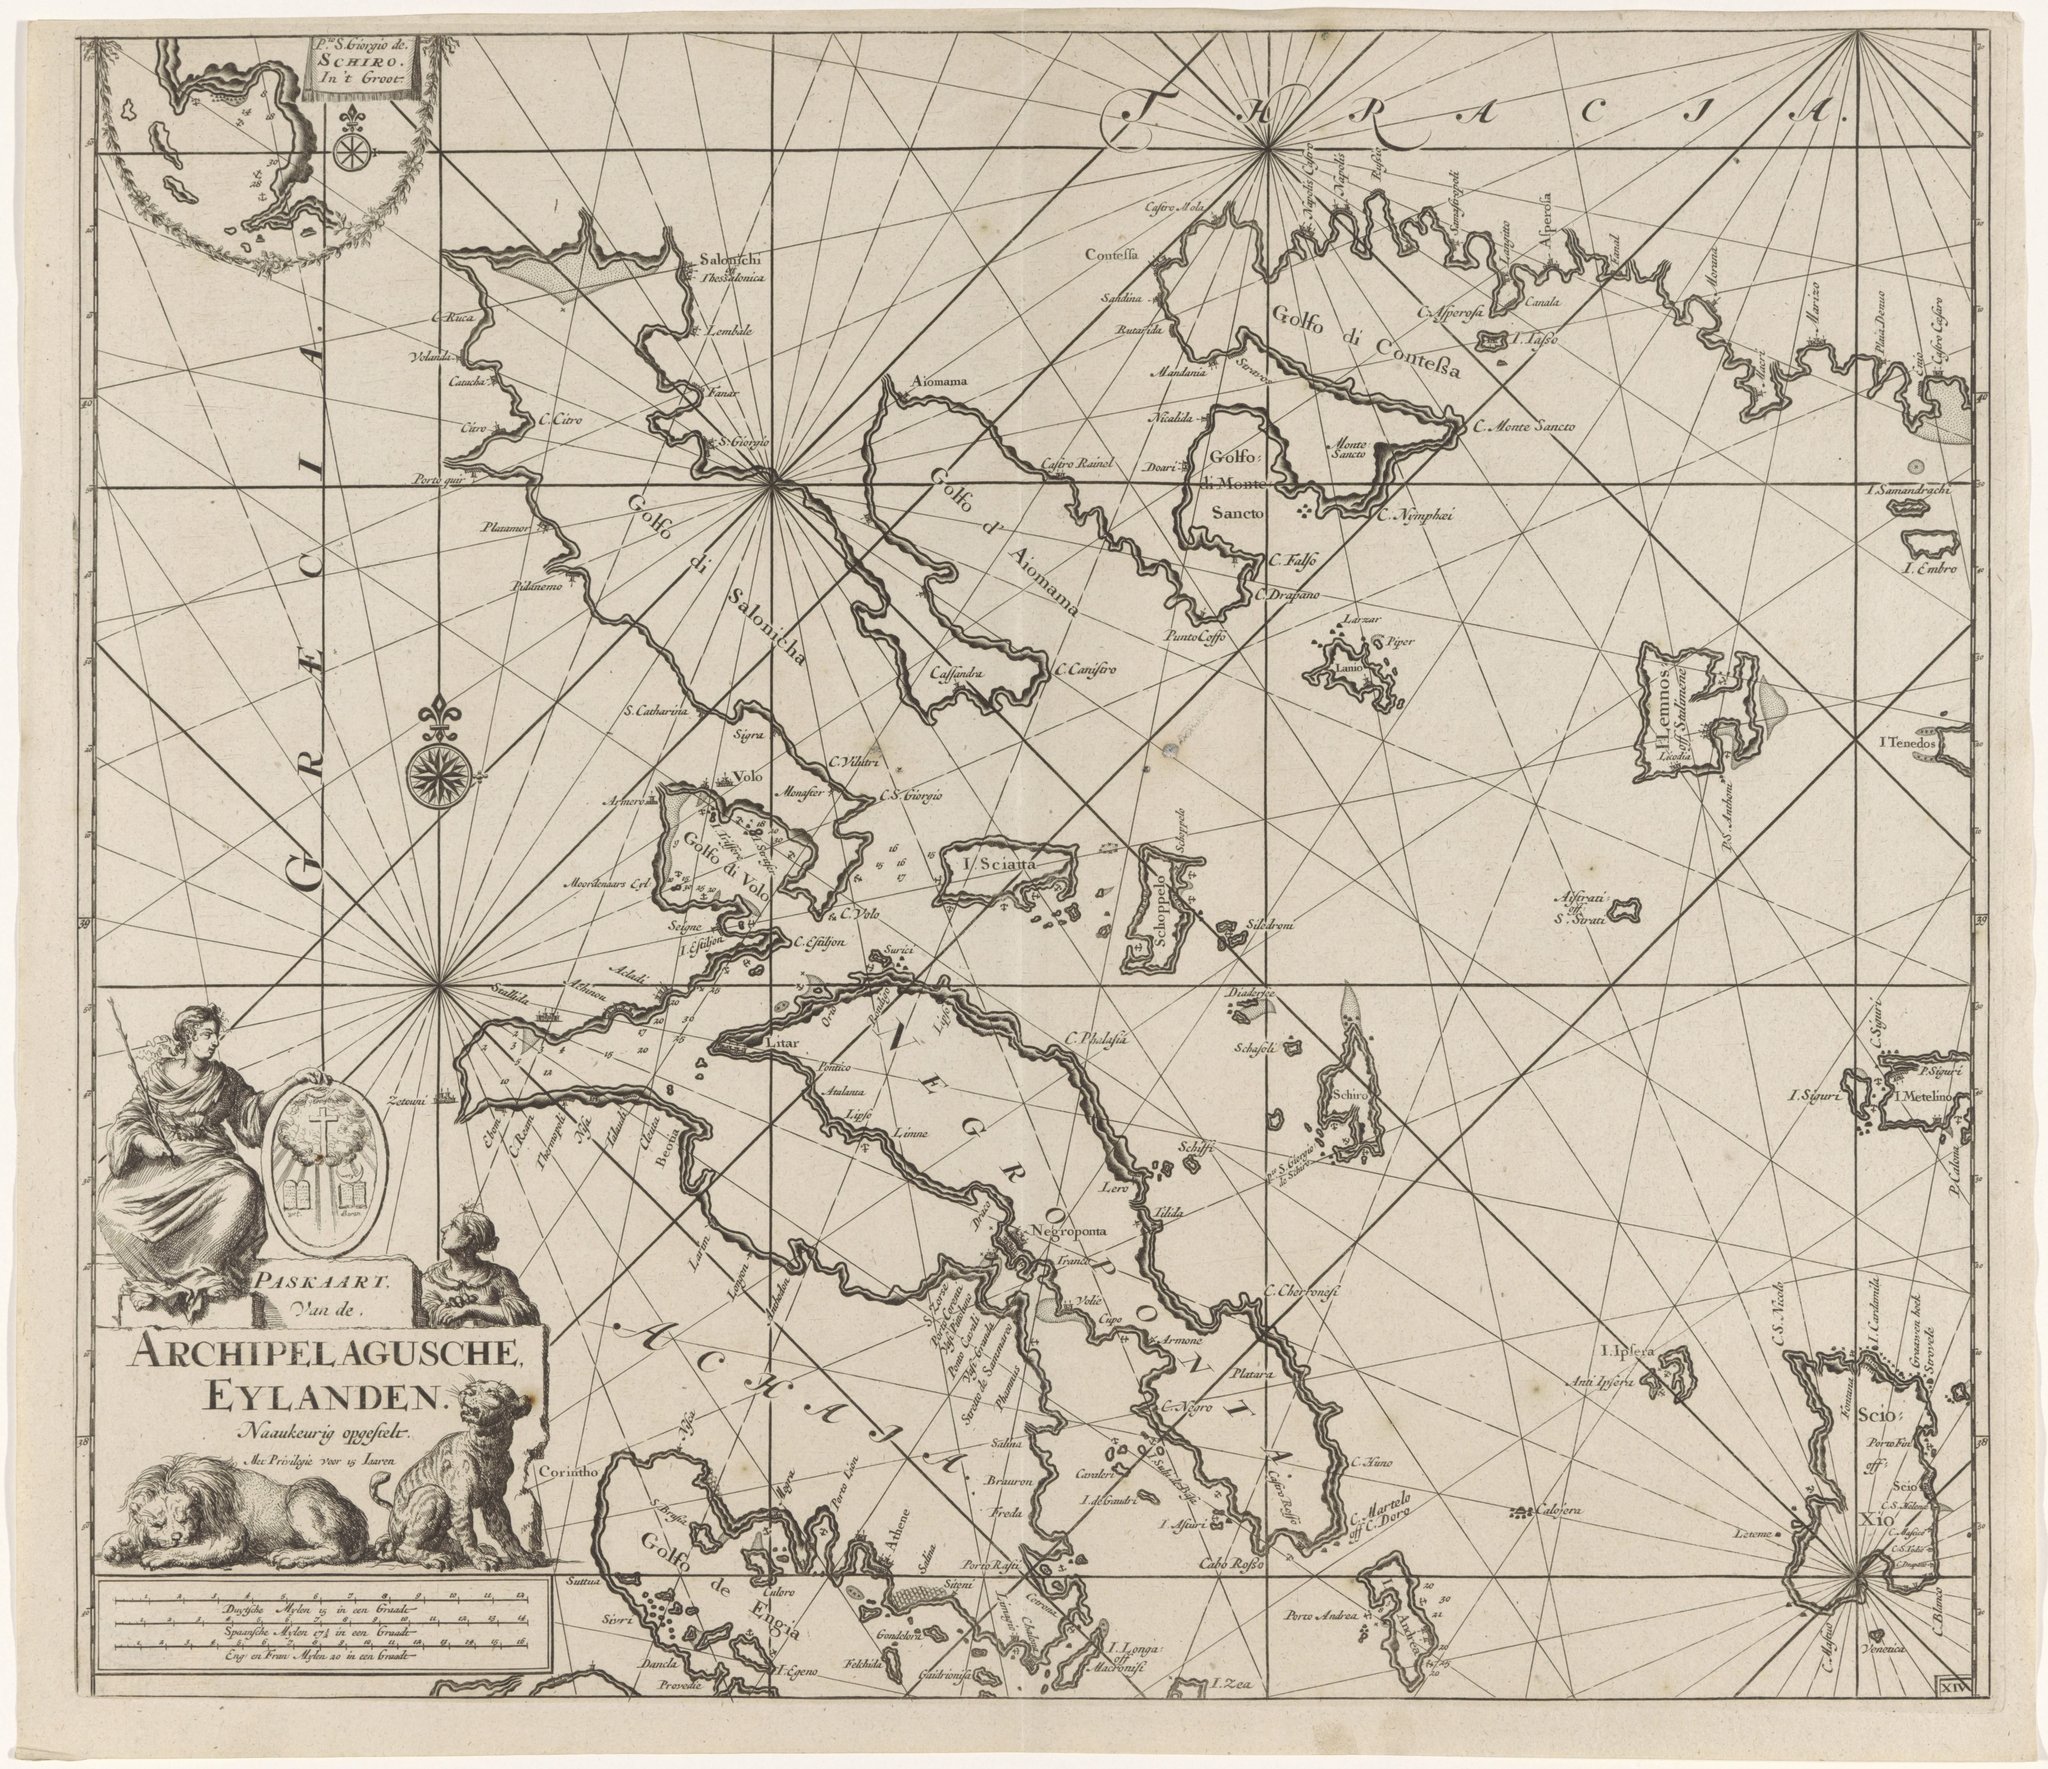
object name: print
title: Paskaart van de Archipelagusche Eylanden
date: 1682-1803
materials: paper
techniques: engraving, etching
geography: amsterdam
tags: places and objects of worship ~ islam, mohammedanism, cross as symbol of christ, beasts of prey, predatory animals: lion, civil law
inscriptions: collector's mark: Lugt 2228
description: Paskaart van het westelijk deel van de Egeïsche Zee met een deel van de kust van Griekenland, met een inzet en twee kompasrozen, het Noorden ligt boven. Linksonder de titel en de schaalverdeling, weergegeven in Duitse, Spaanse en Engelse of Franse mijlen (schaal: c. 1:700.000). Bij deze gegevens een leeuwenpaar en een vrouw met een schild waarop de wet, een kruis en de koran zijn afgebeeld.